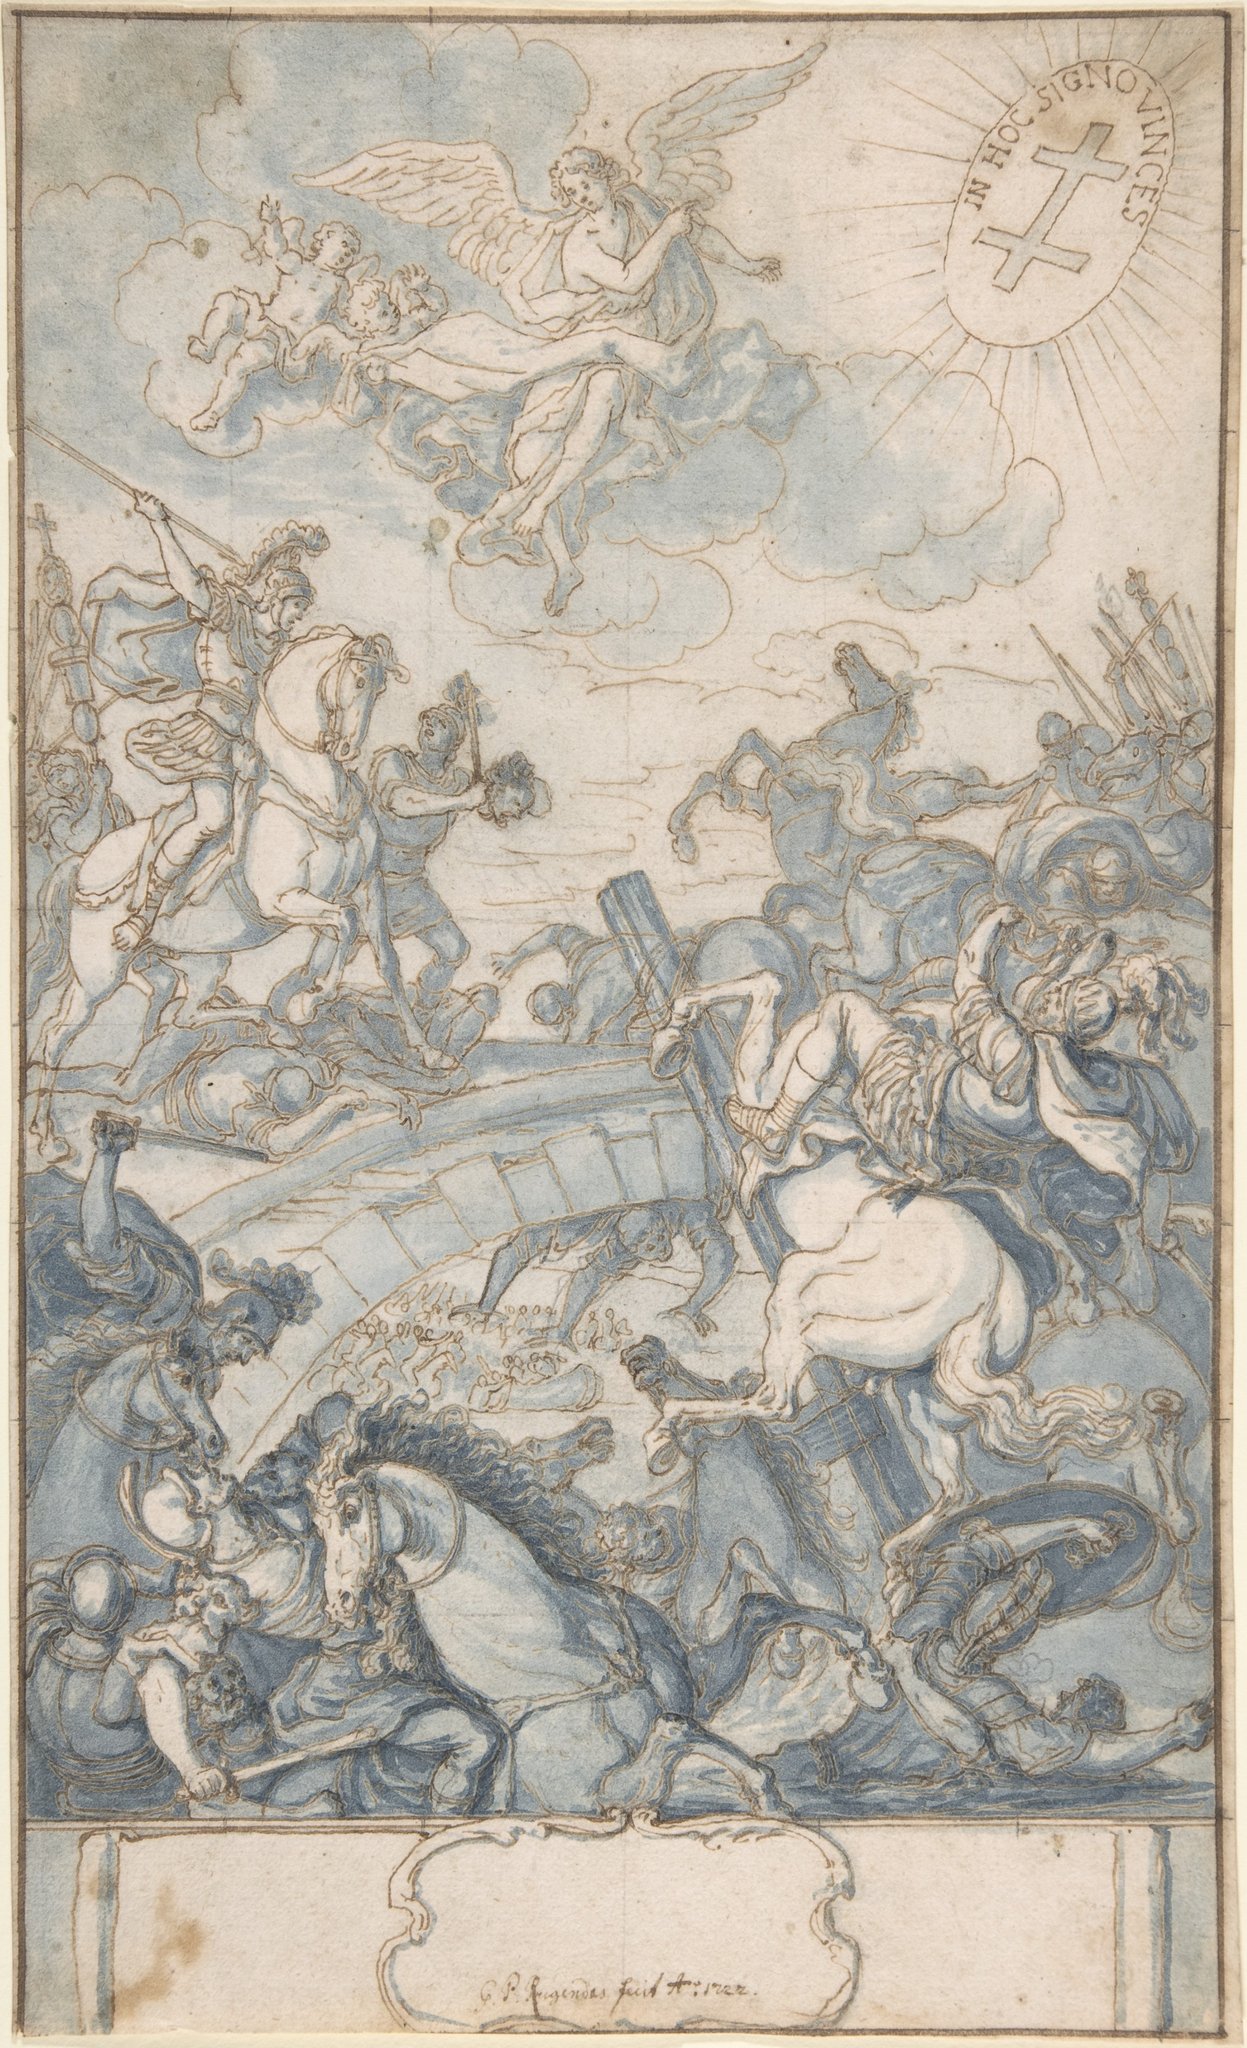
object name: drawing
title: Constantine's Battle at the Milvian Bridge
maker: georg philipp rugendas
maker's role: artist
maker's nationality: german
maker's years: 1666-1743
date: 1722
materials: ink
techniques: brush, pen, wash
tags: bridges,battles,soldiers,horses